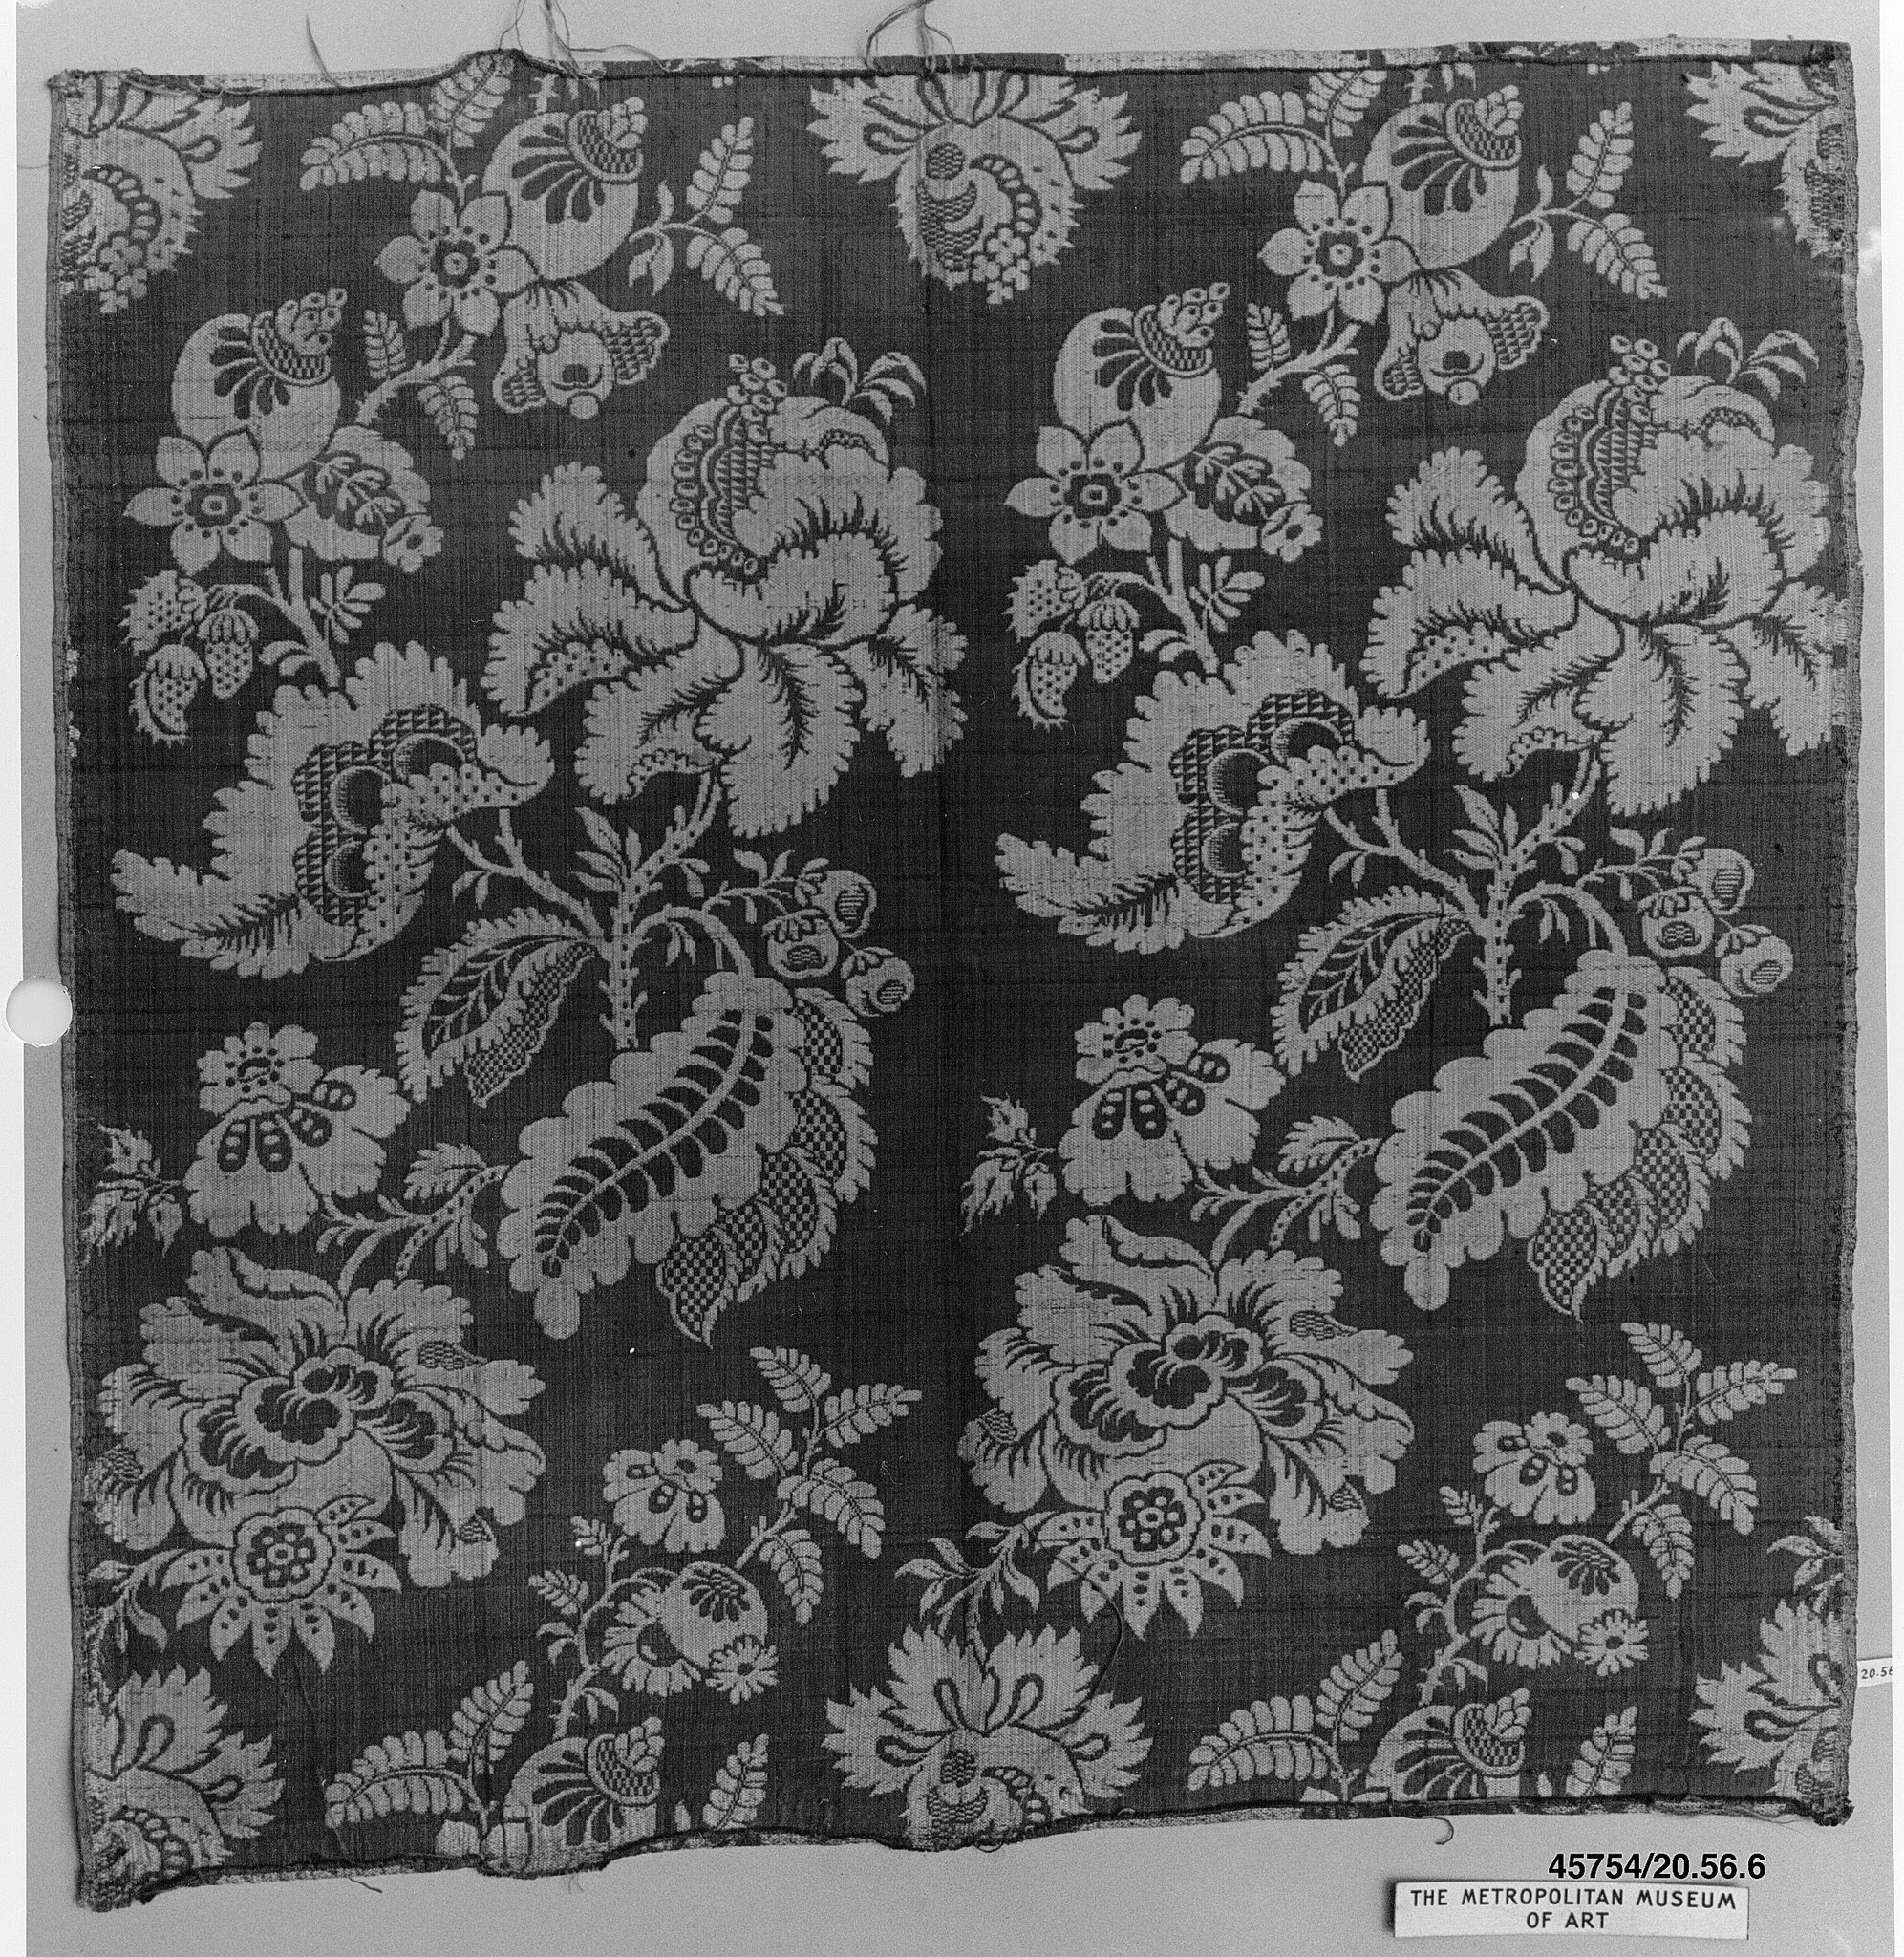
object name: piece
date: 1735-1750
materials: silk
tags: flowers,leaves